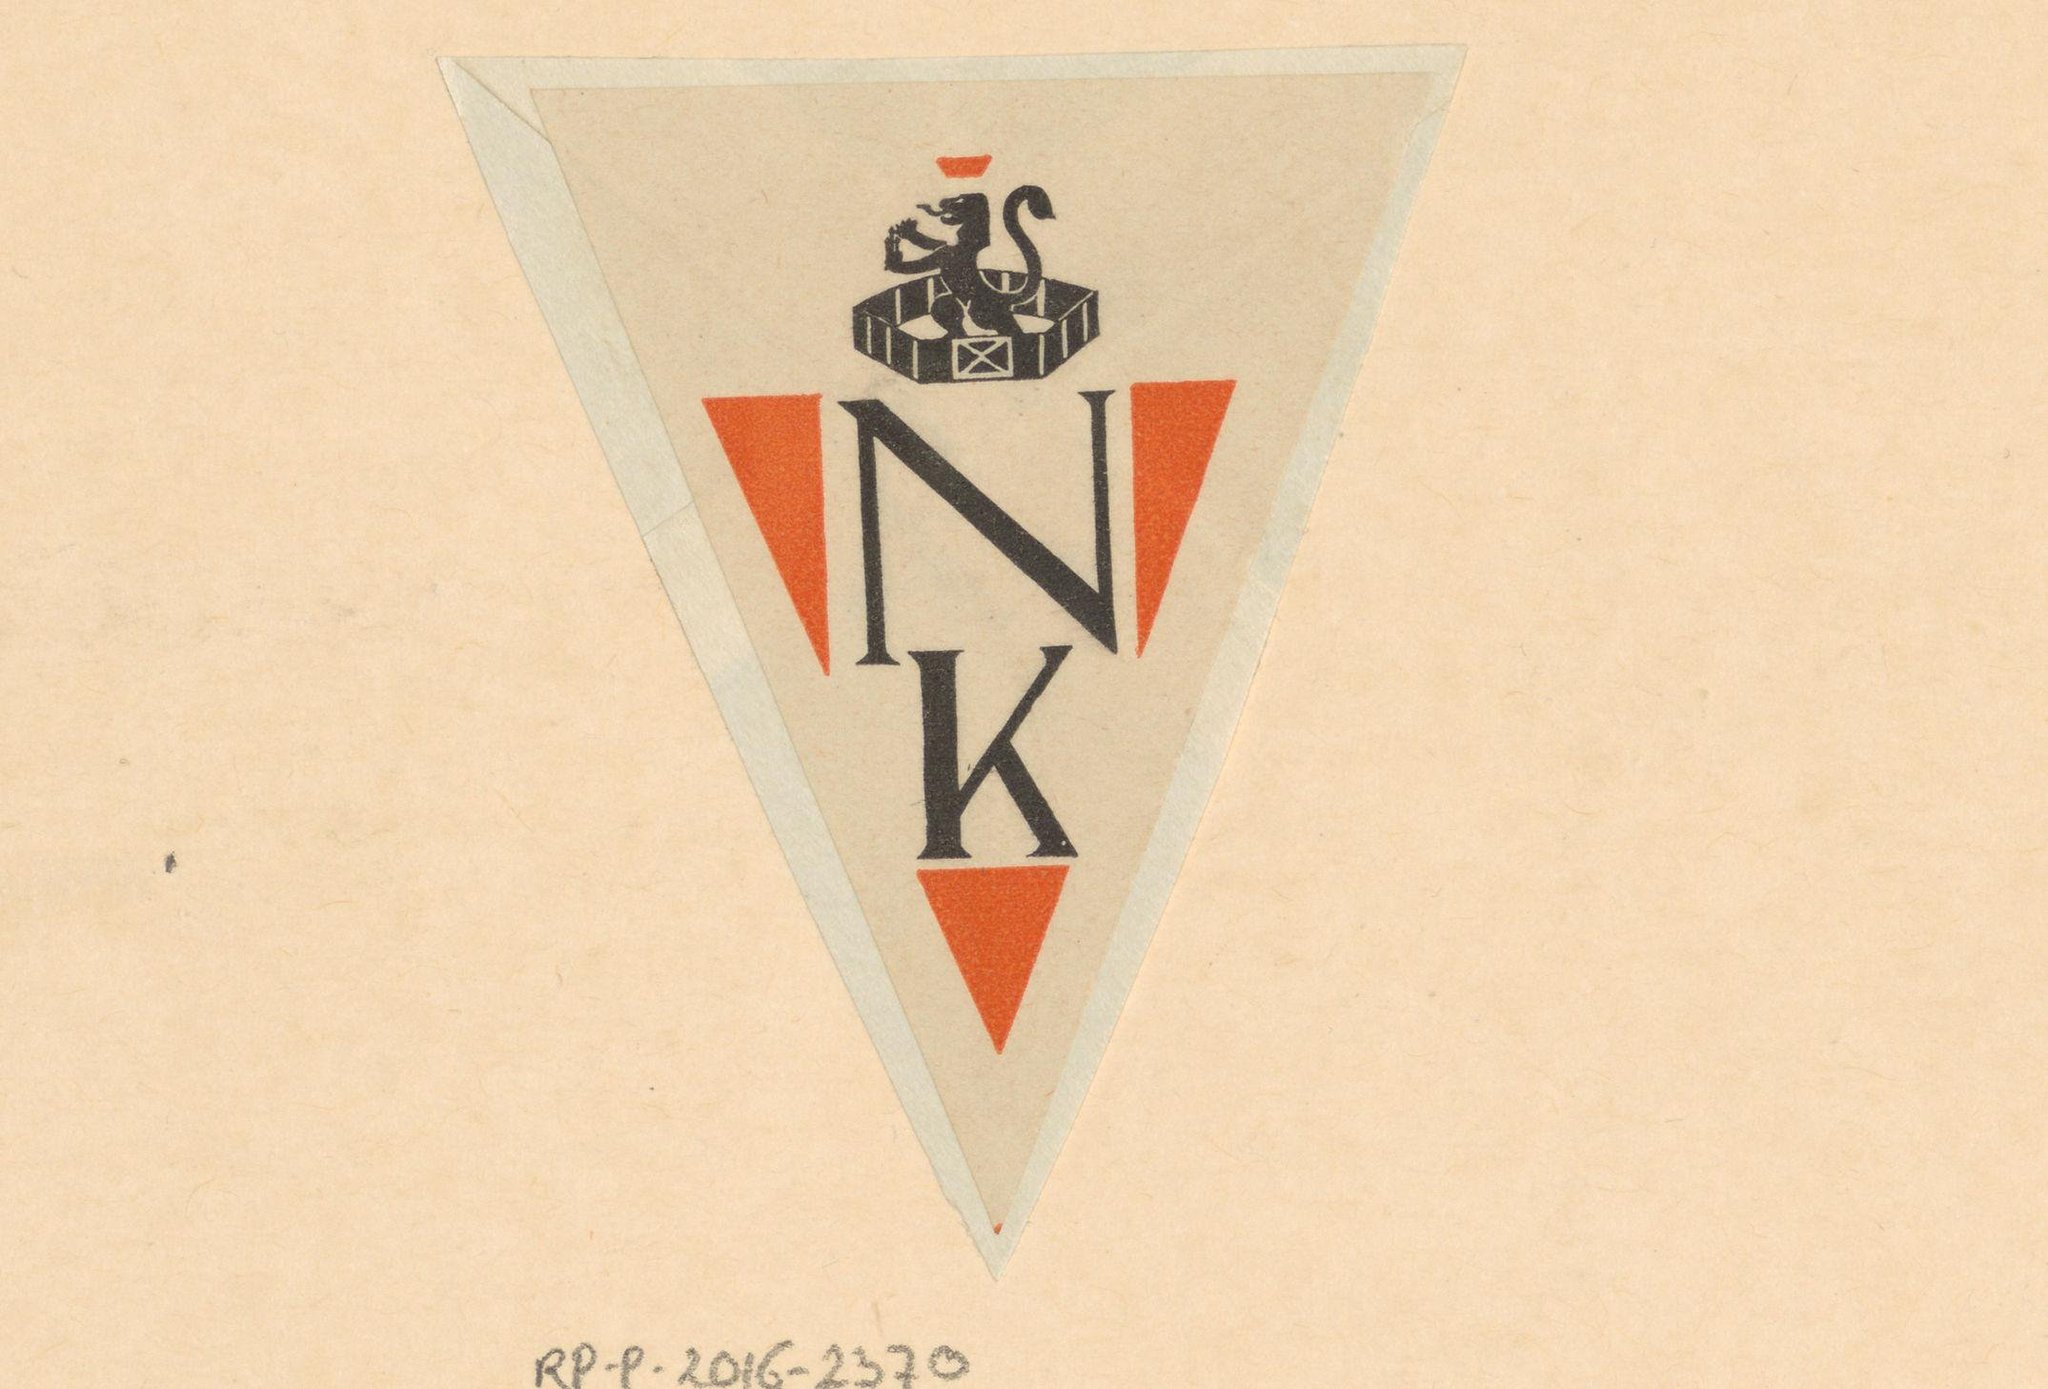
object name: bookplate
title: Ex libris van N.K.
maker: Anonymous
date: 1900-1950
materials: paper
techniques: printing block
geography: netherlands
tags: personifications of countries, nations, states, districts, etc., beasts of prey, predatory animals: lion